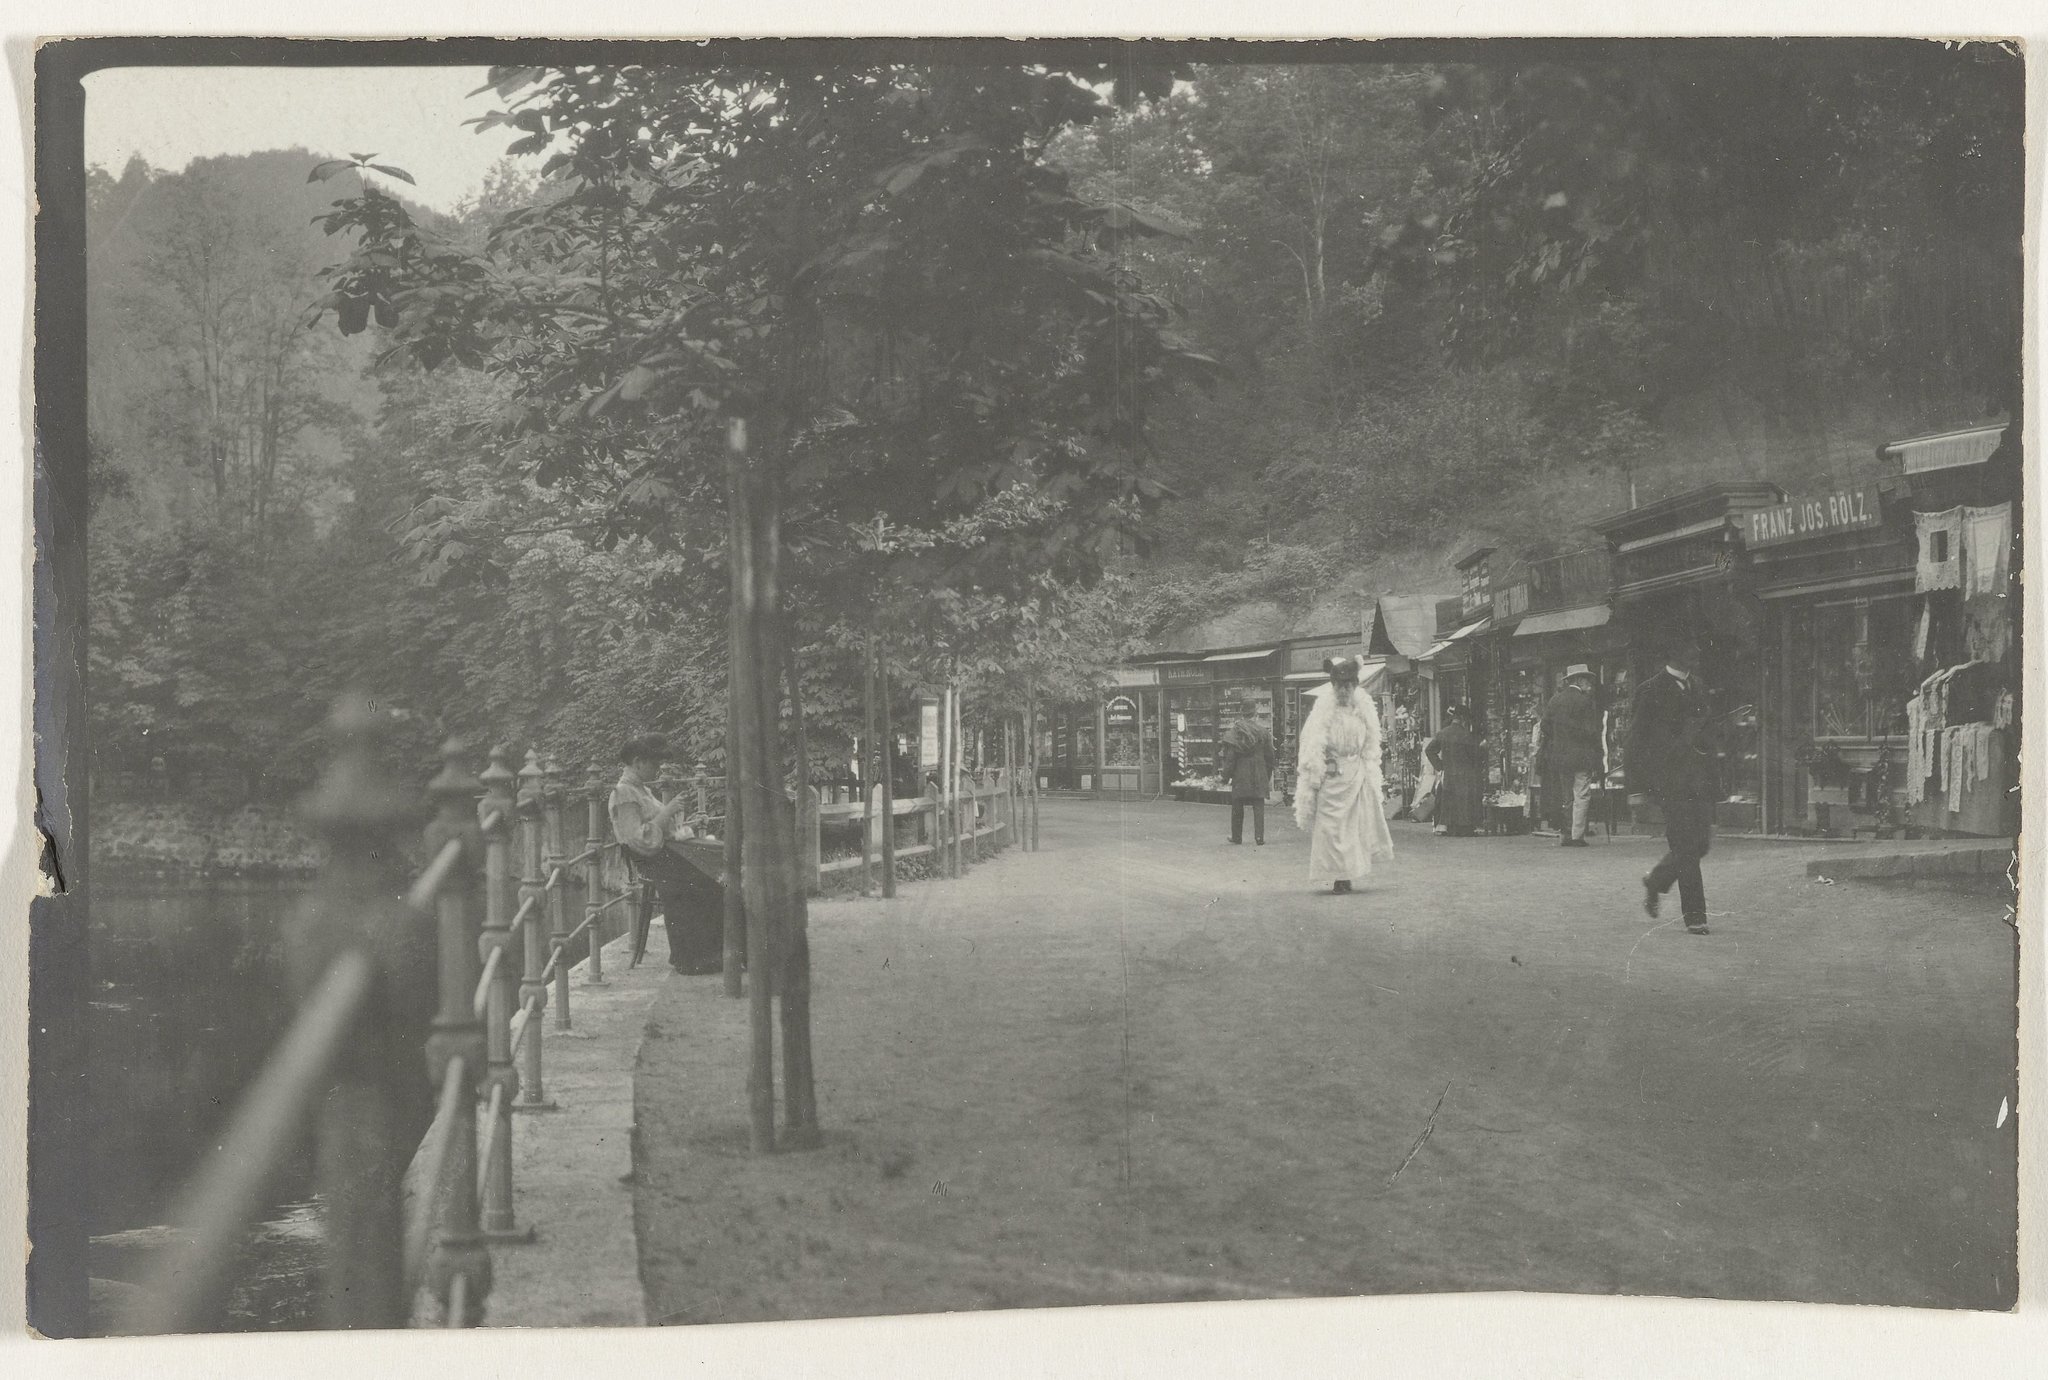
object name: photograph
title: Winkels aan de oever van een water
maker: Anonymous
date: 1900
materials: paper, photographic support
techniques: gelatin silver print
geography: germany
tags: water course (+ landscape with figures, staffage)